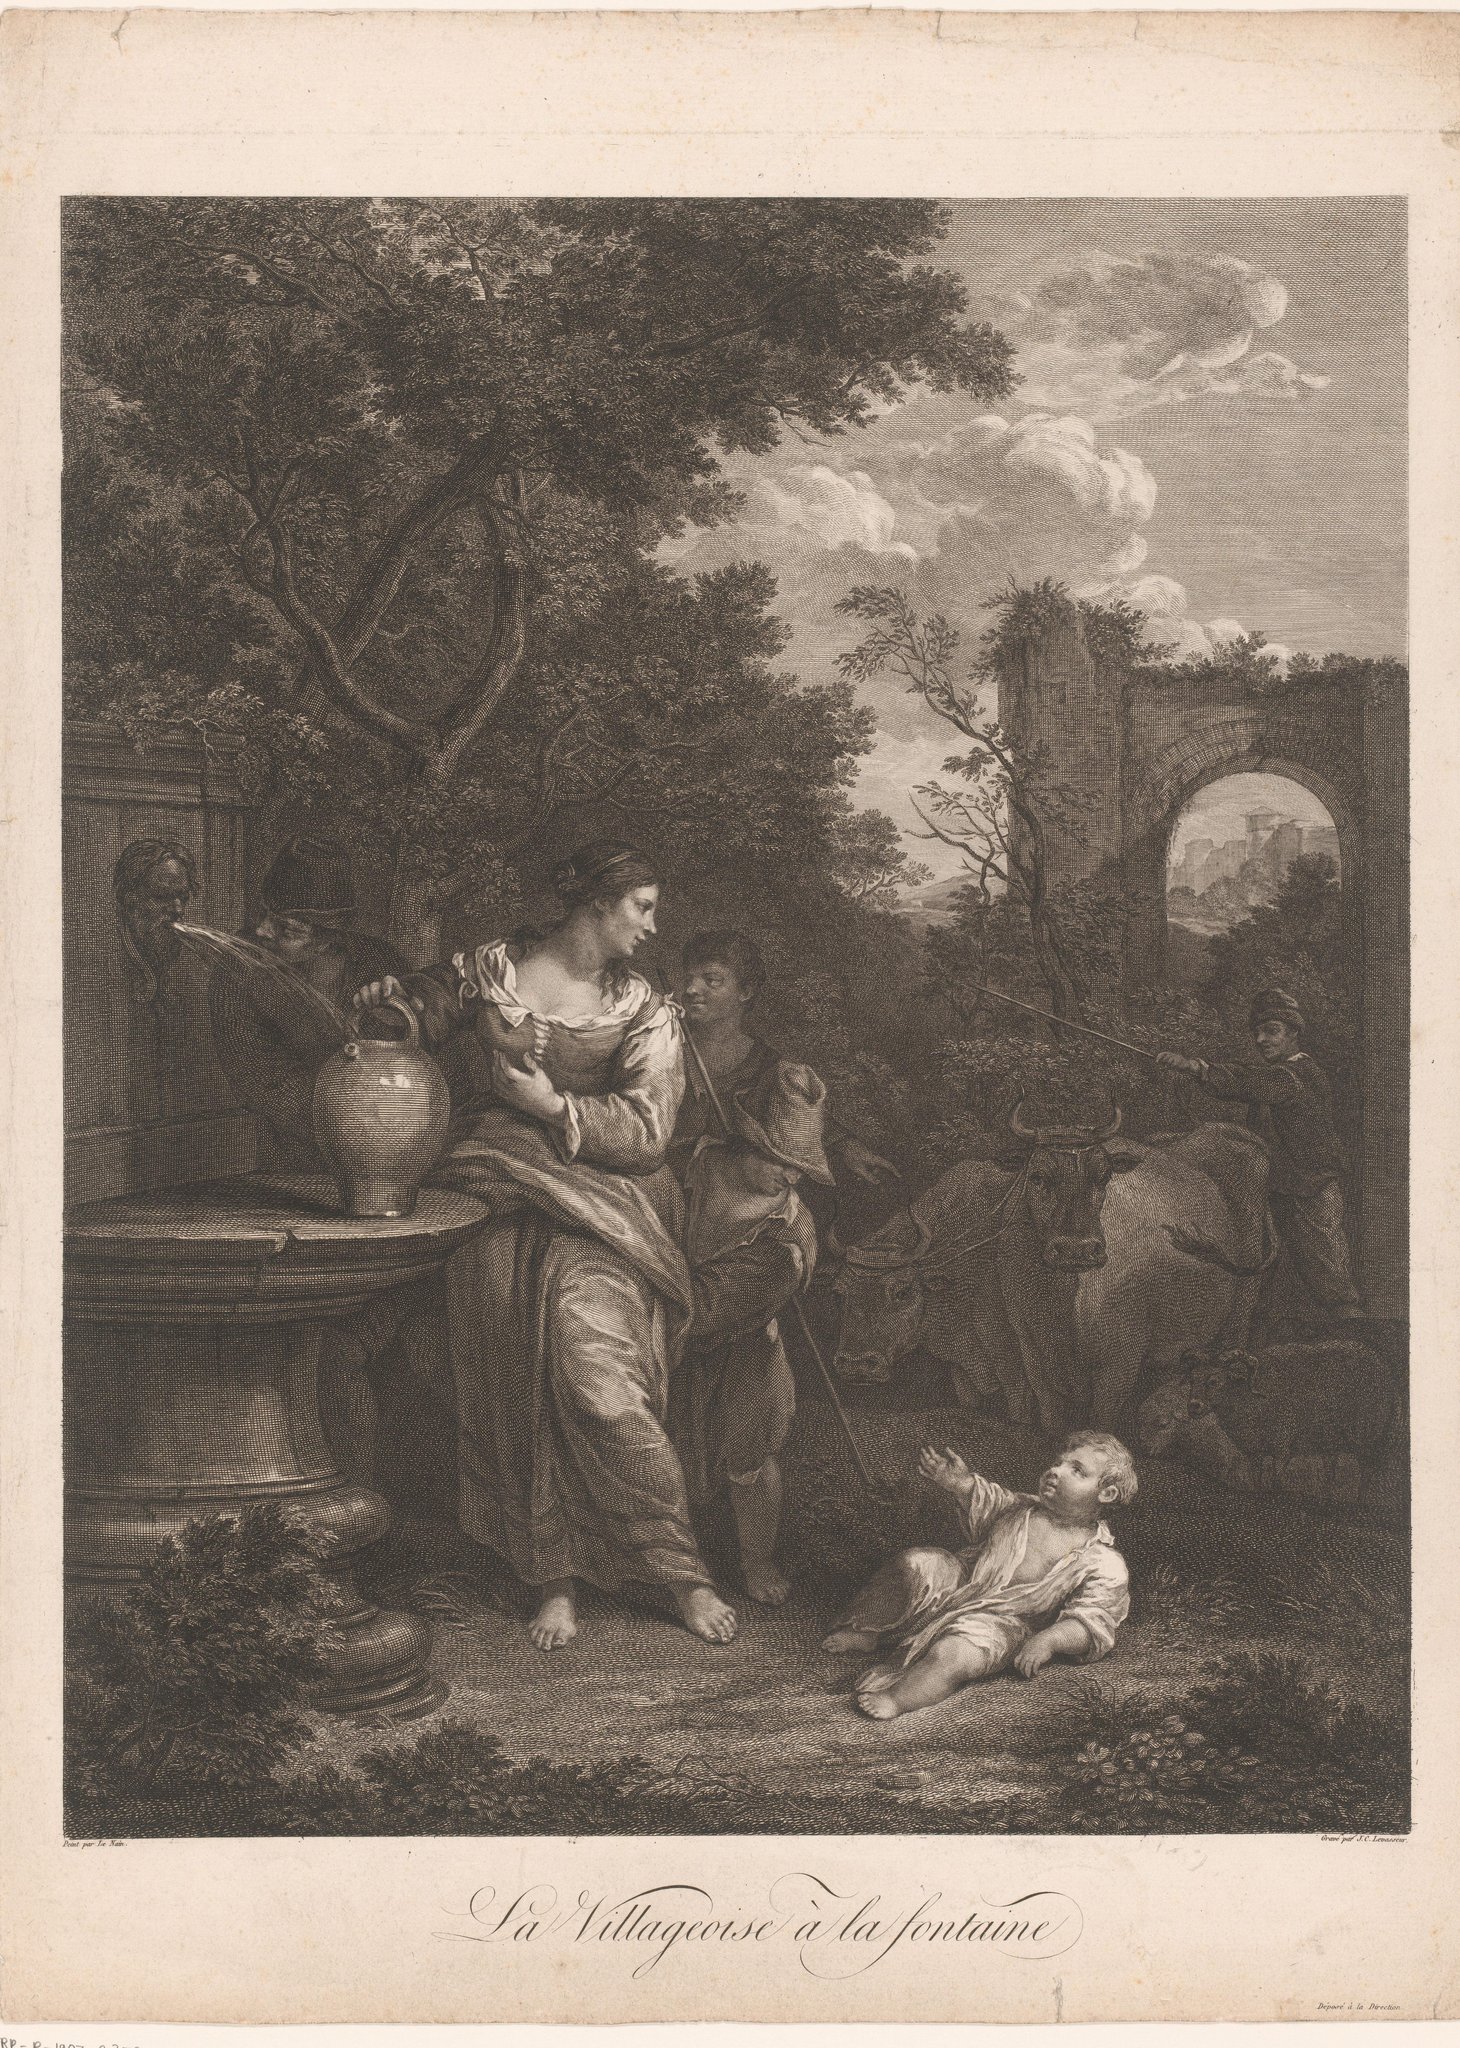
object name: print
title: Herders en reizigers bij een fontein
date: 1744-1816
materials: paper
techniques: engraving, etching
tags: herding, herdsman, herdswoman, shepherd, shepherdess, cowherd, etc., 'en route', traveller under way, utilitarian, public pump or water fountain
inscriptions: : ‘Déposé à la Direction.’, collector's mark: Lugt 2228